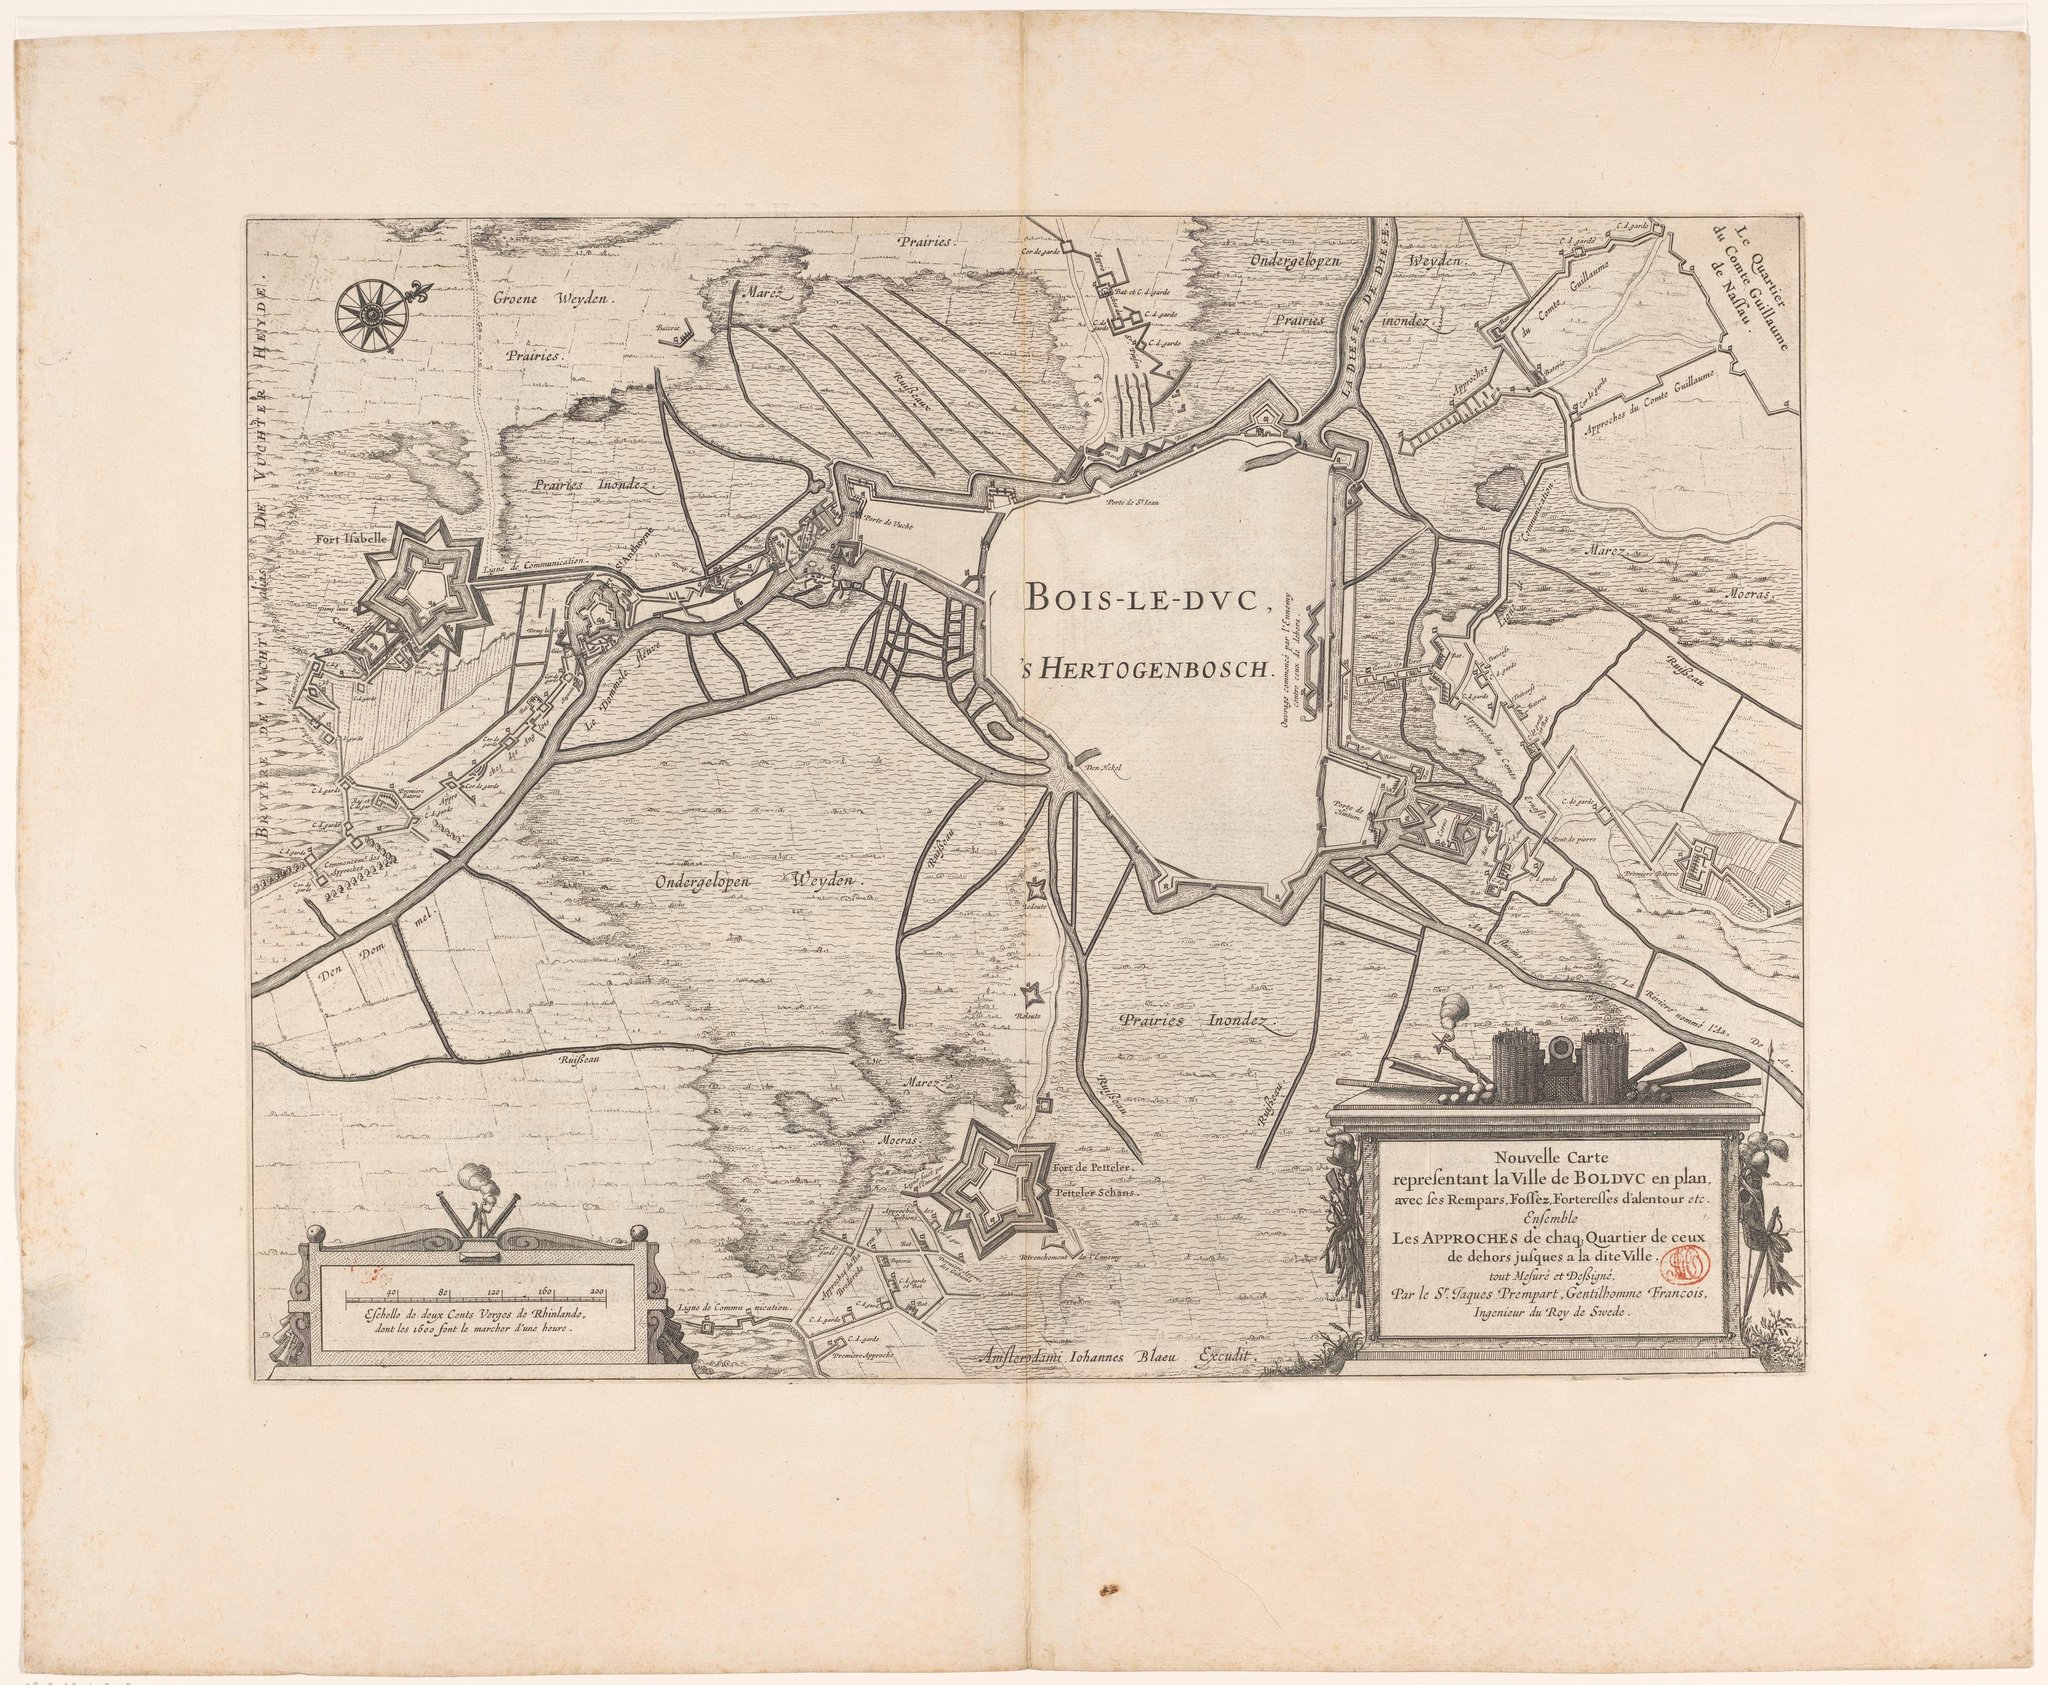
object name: print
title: Kaart van het beleg van Den Bosch door Frederik Hendrik, 1629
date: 1652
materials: paper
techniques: engraving, etching, letterpress printing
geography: northern netherlands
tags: frederick henry (prince of orange), maps of separate countries or regions, siege, position war, den bosch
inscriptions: collector's mark: Lugt 195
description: Kaart van het beleg van Den Bosch door het Staatse leger onder Frederik Hendrik, van 1 mei tot 17 september 1629. Kaart met centraal de versterkte stad, links fort Isabella. Rechtsonder een cartouche met de Franse titel. Linksonder een cartouche met schaalstok: Eschelle de deux Cents Verges de Rhinlande, dont les 1600 font le marcher d'une heure. Nederlandse tekst op verso.